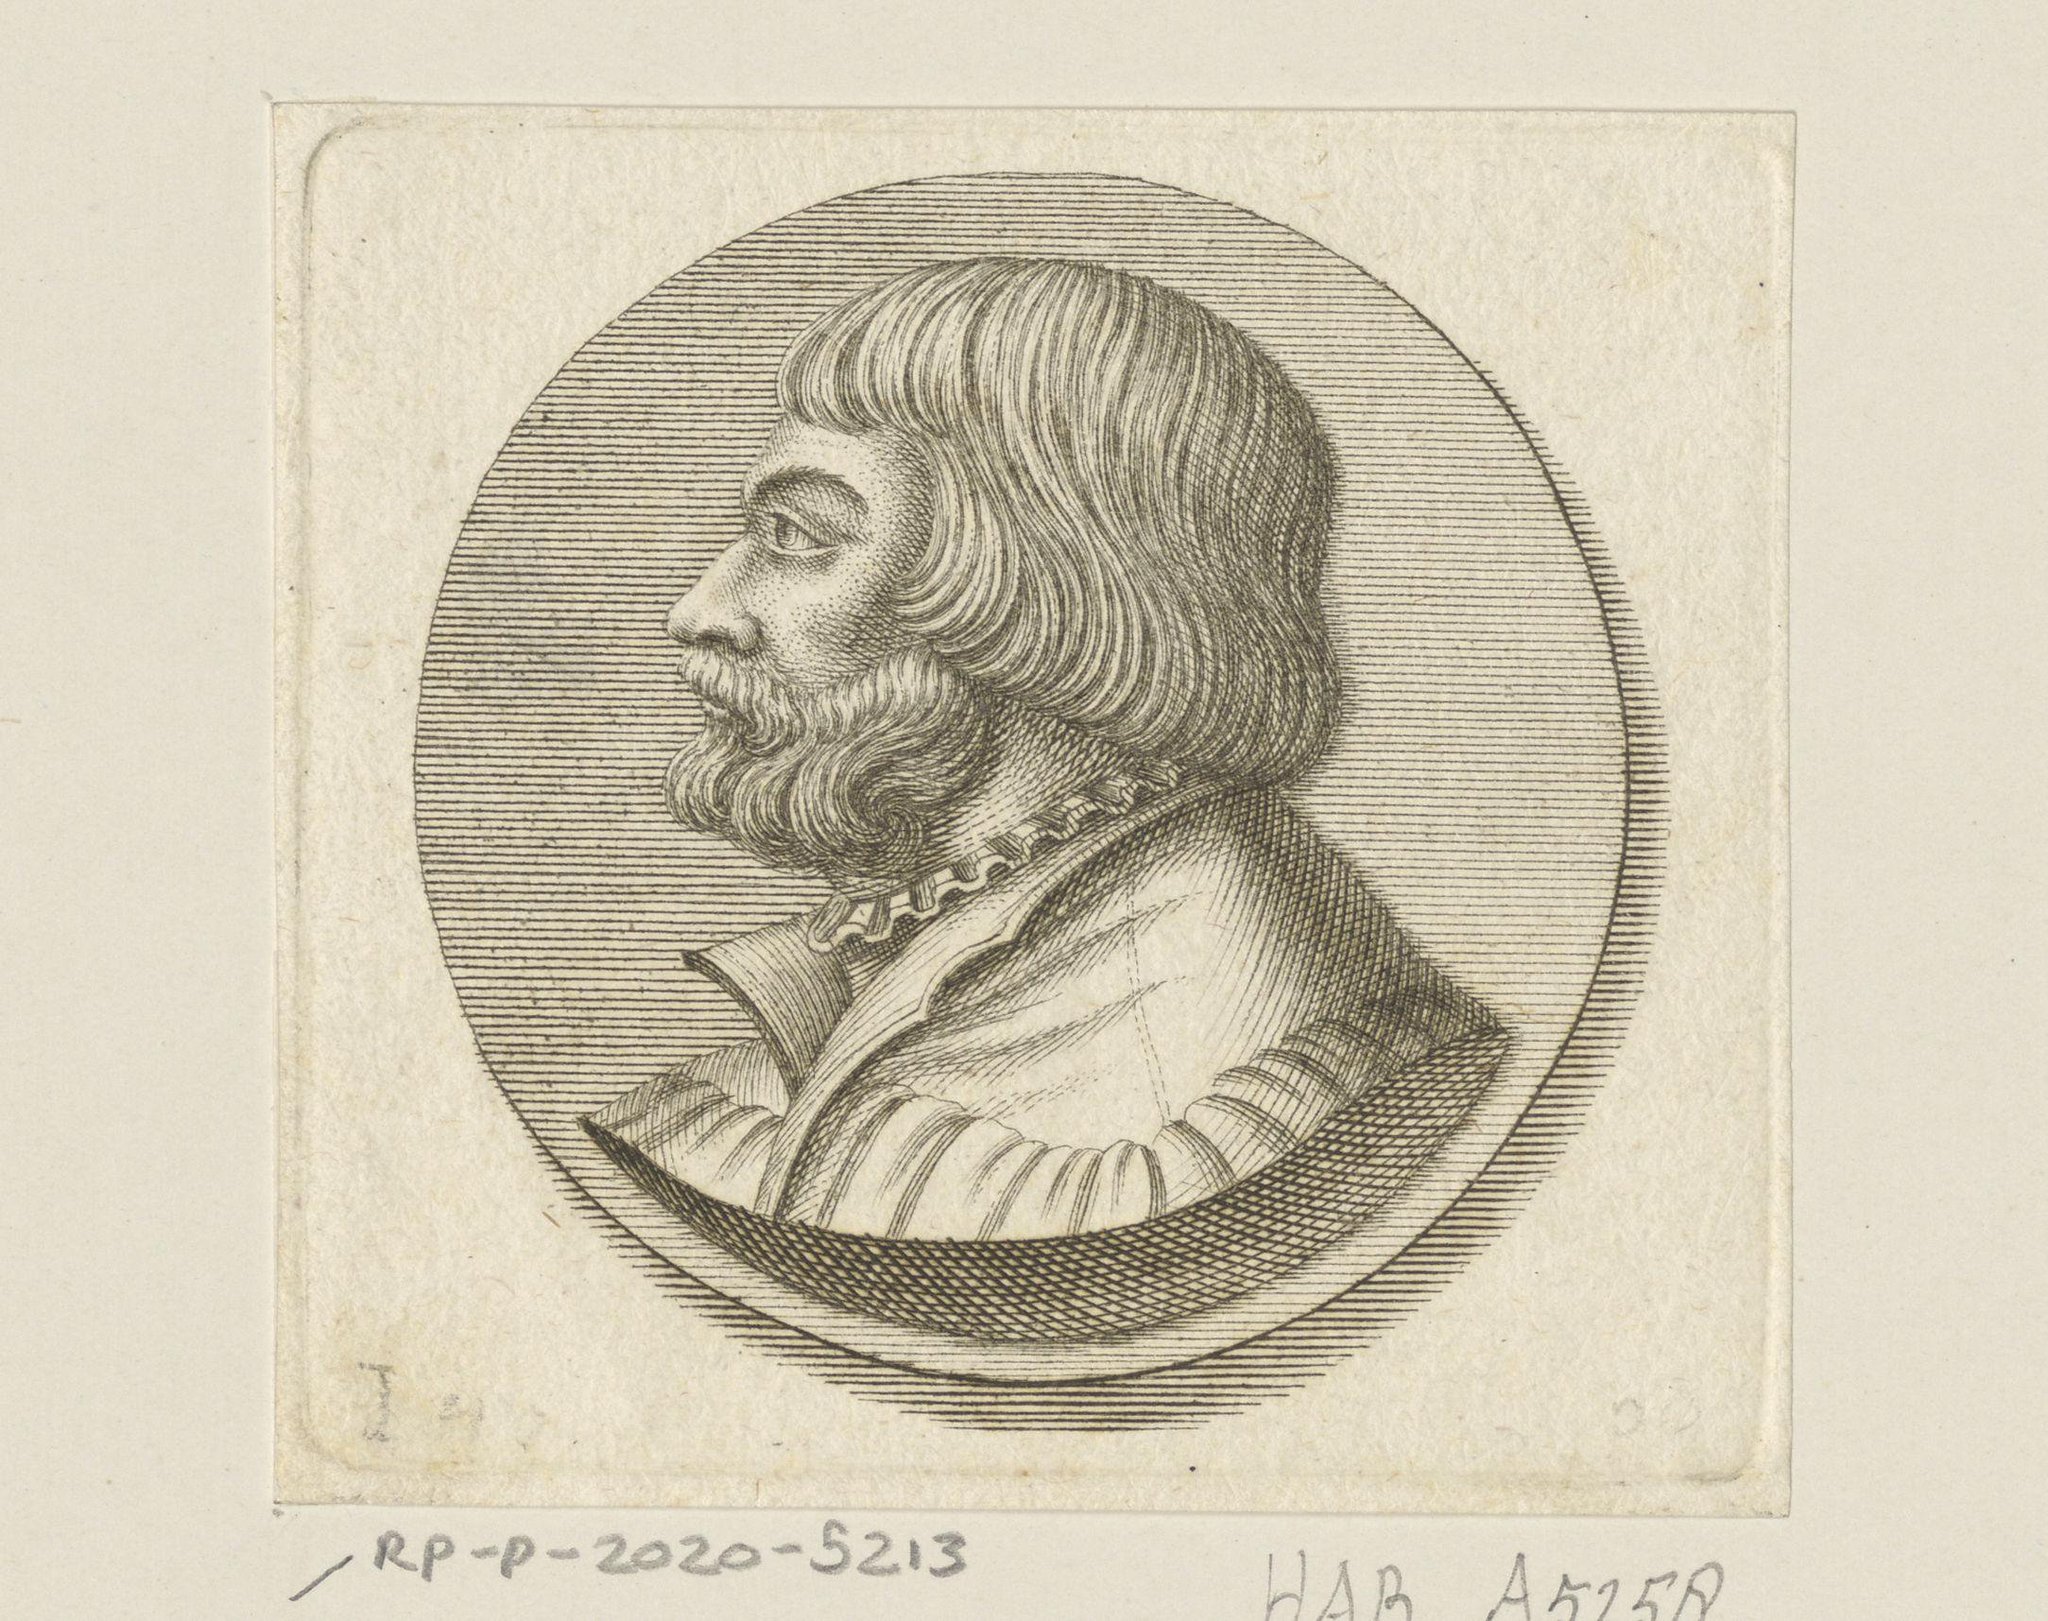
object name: print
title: Portret van Albrecht Dürer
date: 1764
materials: paper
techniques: engraving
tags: painter, print maker, draughtsman, albrecht dürer, historical persons, portrait, self-portrait of painter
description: Prent mogelijk uit: Will, Georg Andreas. Der nürnbergische Münzbelustigungen (...). Altdorf: Georg Peter Monath, 1764, dl. 1.